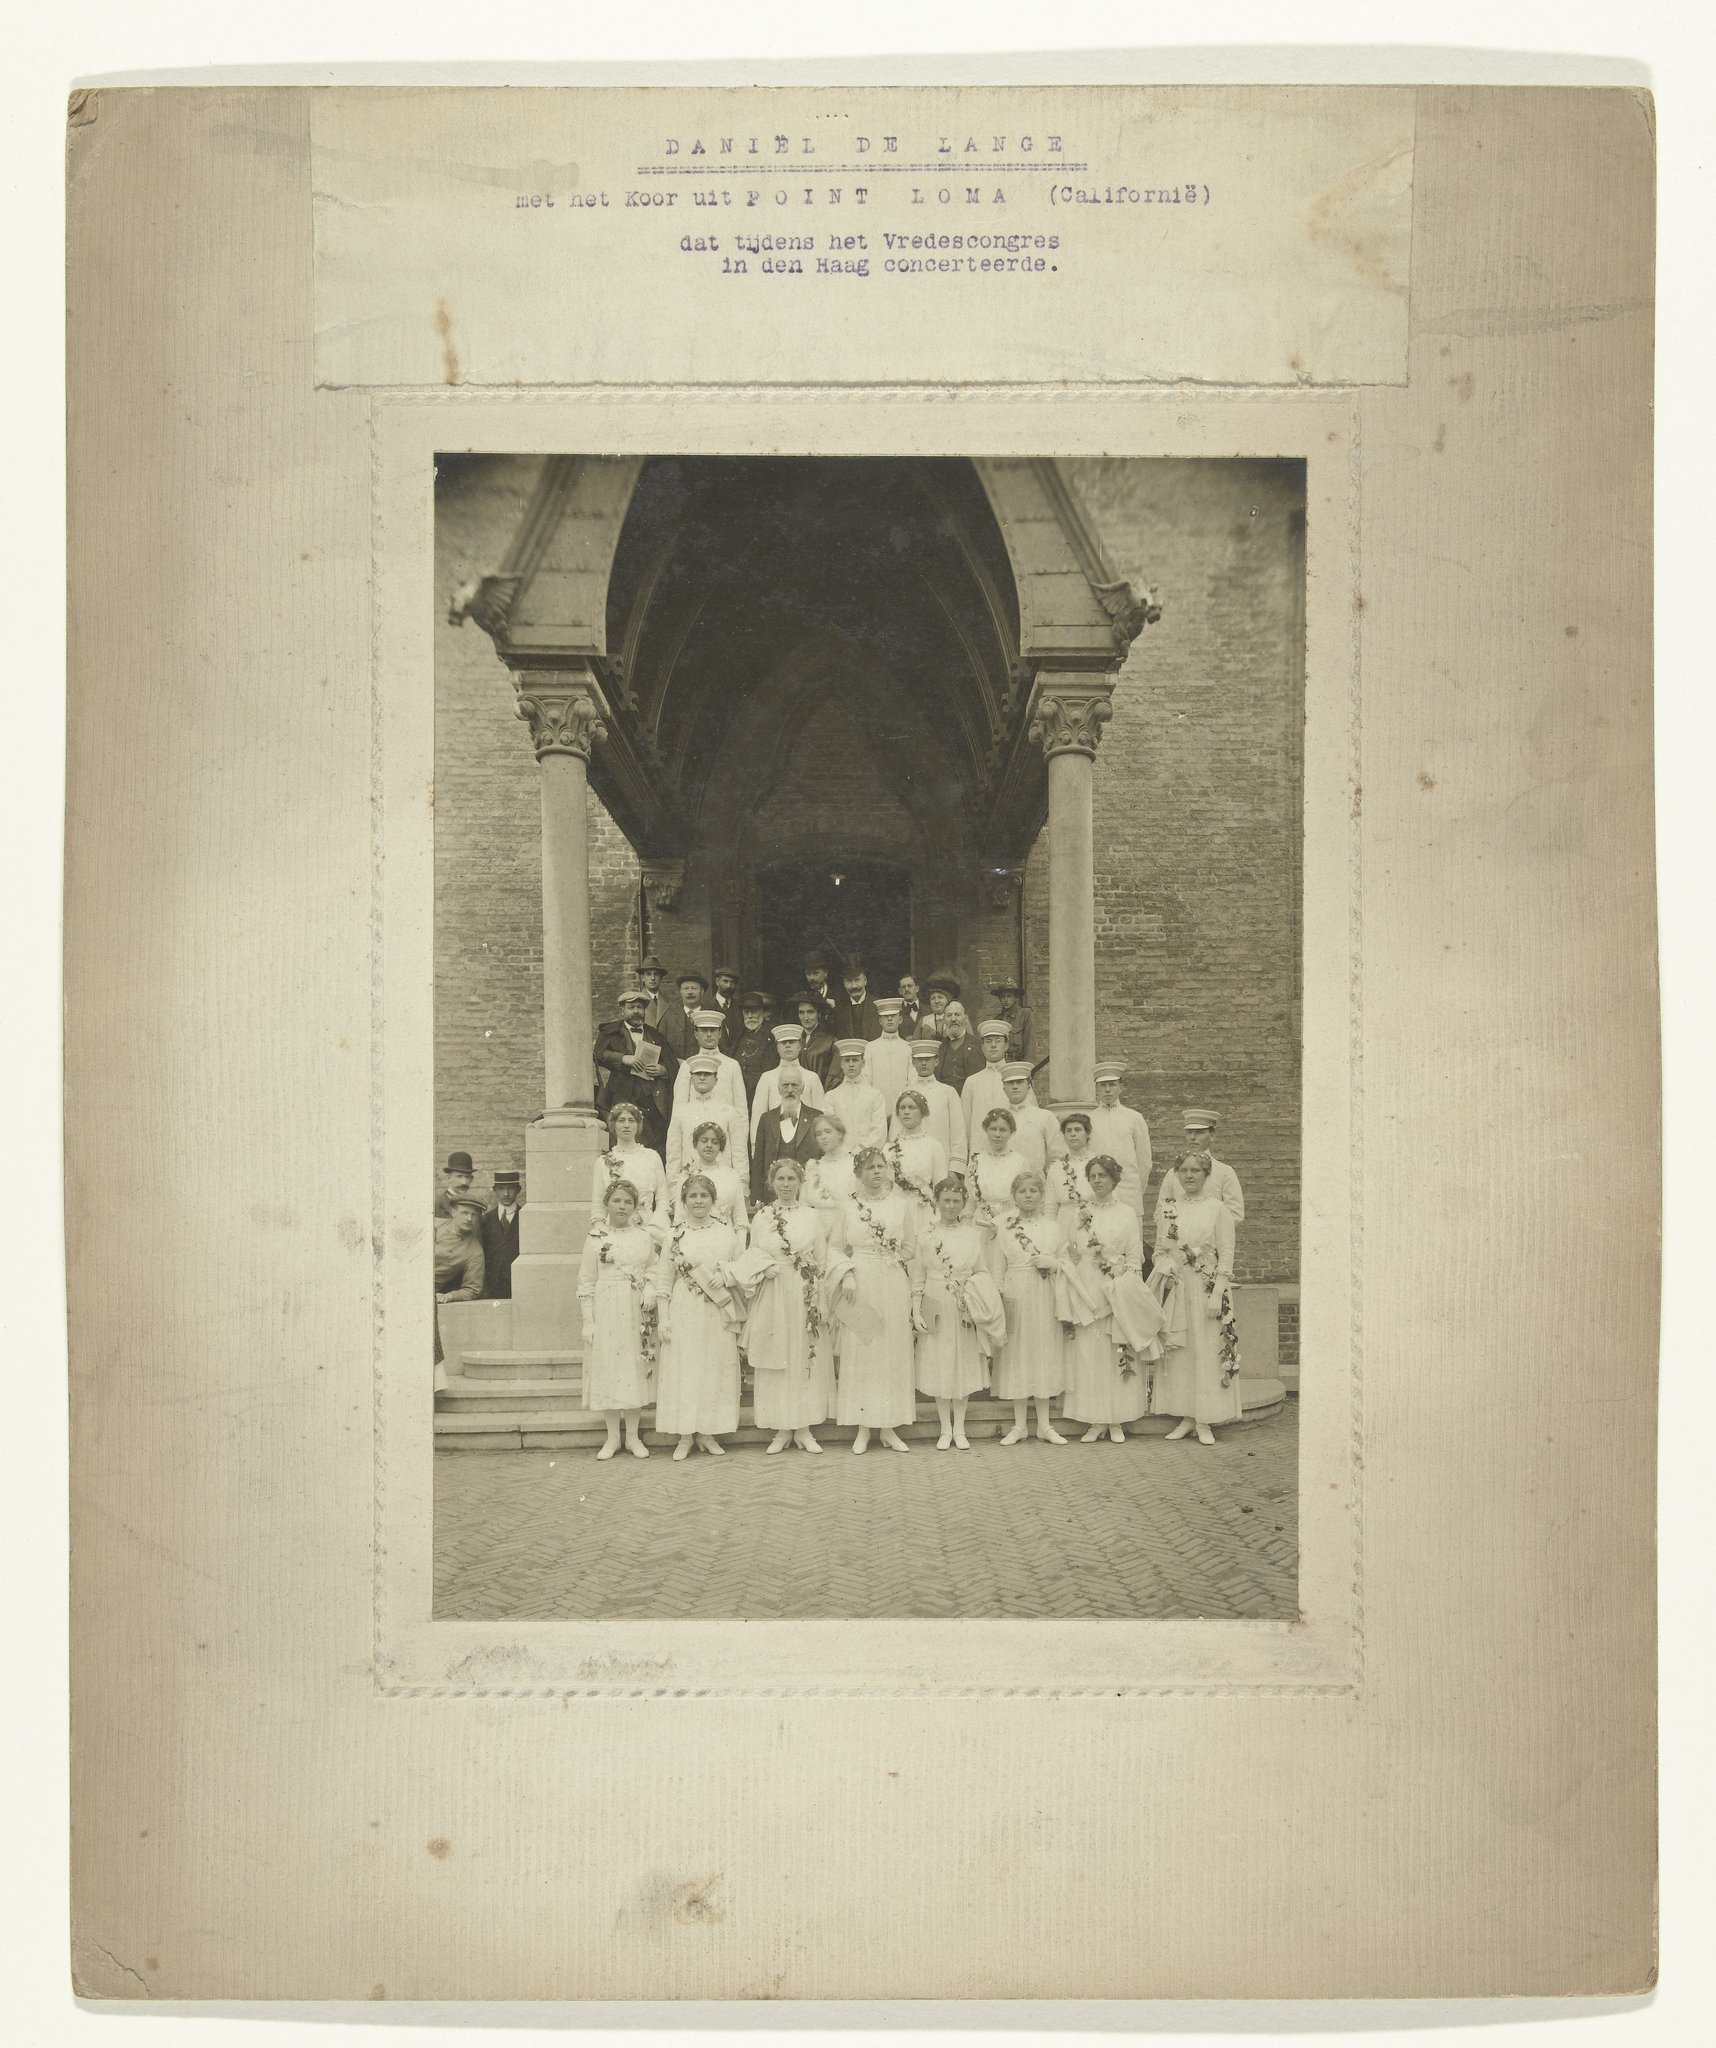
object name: photograph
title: Groepsportret van een in het wit gekleede groep mannen in kostuum voor het vredespaleis in Den Haag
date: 1900-1940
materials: paper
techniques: gelatin silver print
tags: anonymous historical persons portrayed in a group, in a group-portrait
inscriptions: title: ‘Daniël de Lange met het koor uit Point Loma (Californië) dat tijdens het Vredescongres in Den Haag concerteerde’, stamp: ‘Haagsch Illustratie en Persbureau, Hofwyckstraat 34, telefoon 7230 's Gravenhage.’